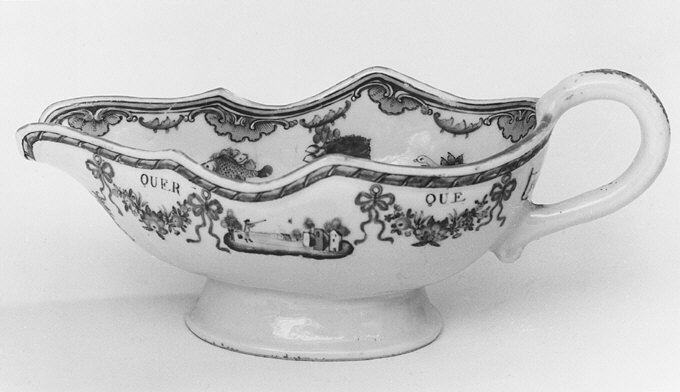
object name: sauceboat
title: Sauceboat (part of a service)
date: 1765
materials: hard paste porcelain